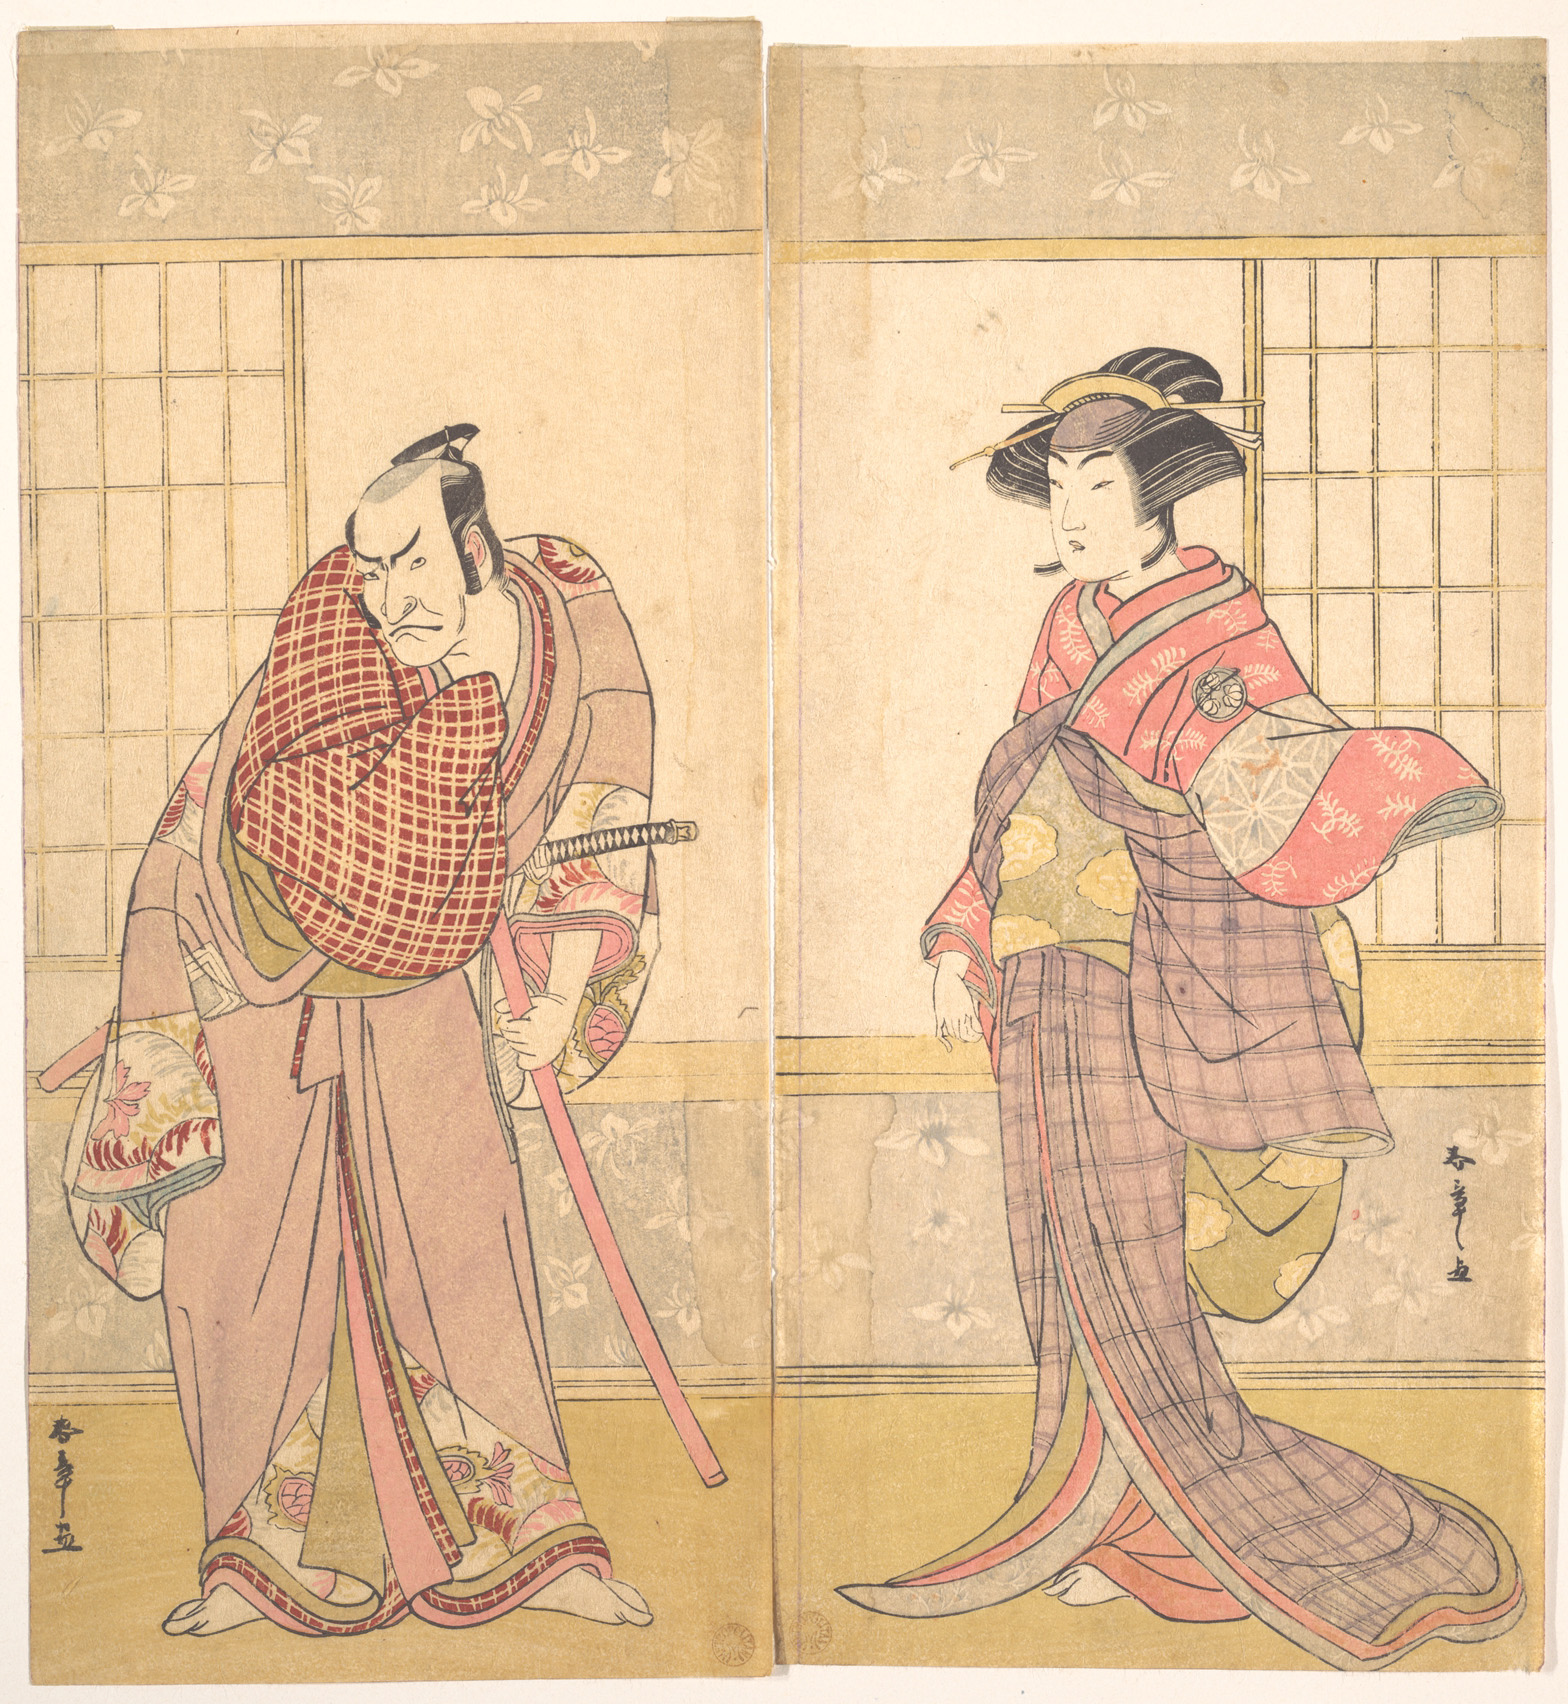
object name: woodblock print nishiki e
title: The Fifth Ichikawa Danjuro as a Man Standing in a Room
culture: japanese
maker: katsukawa shunshō 勝川春章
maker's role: artist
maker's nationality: japanese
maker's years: 1726-1792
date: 1780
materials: ink, paper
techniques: nishiki e, woodblock print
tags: men,women